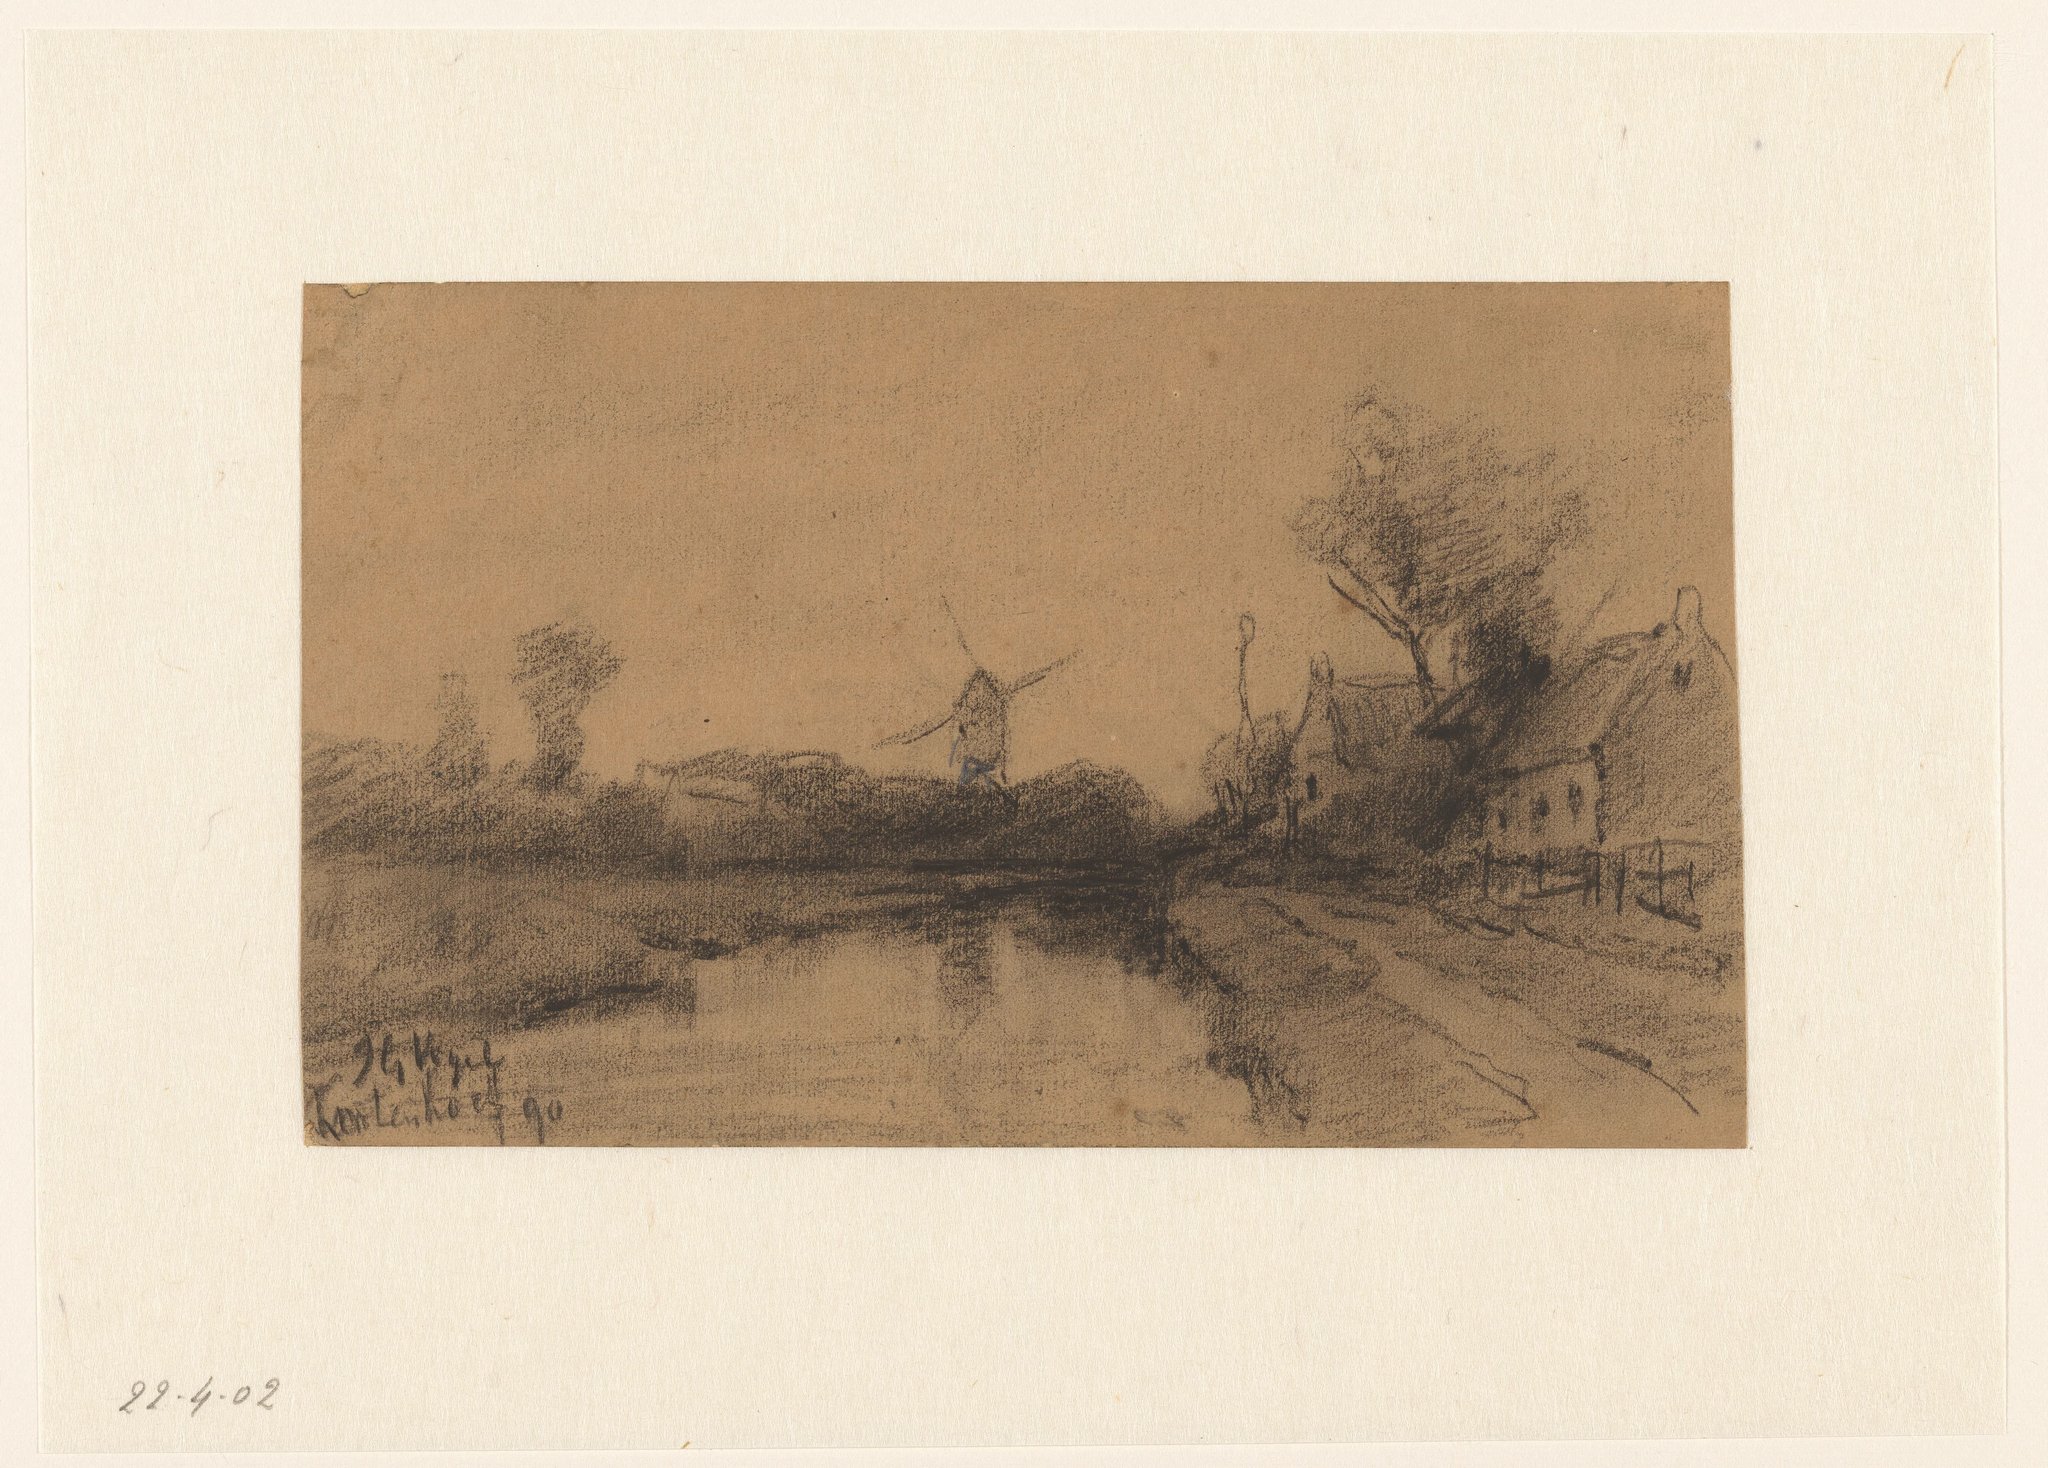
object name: drawing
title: Molen aan het water bij Kortenhoef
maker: johannes gijsbert vogel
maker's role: draughtsman, painter, print maker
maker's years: 1828-1915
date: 1890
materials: chalk, paper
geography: kortenhoef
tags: factories and mills in landscape, windmill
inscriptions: date